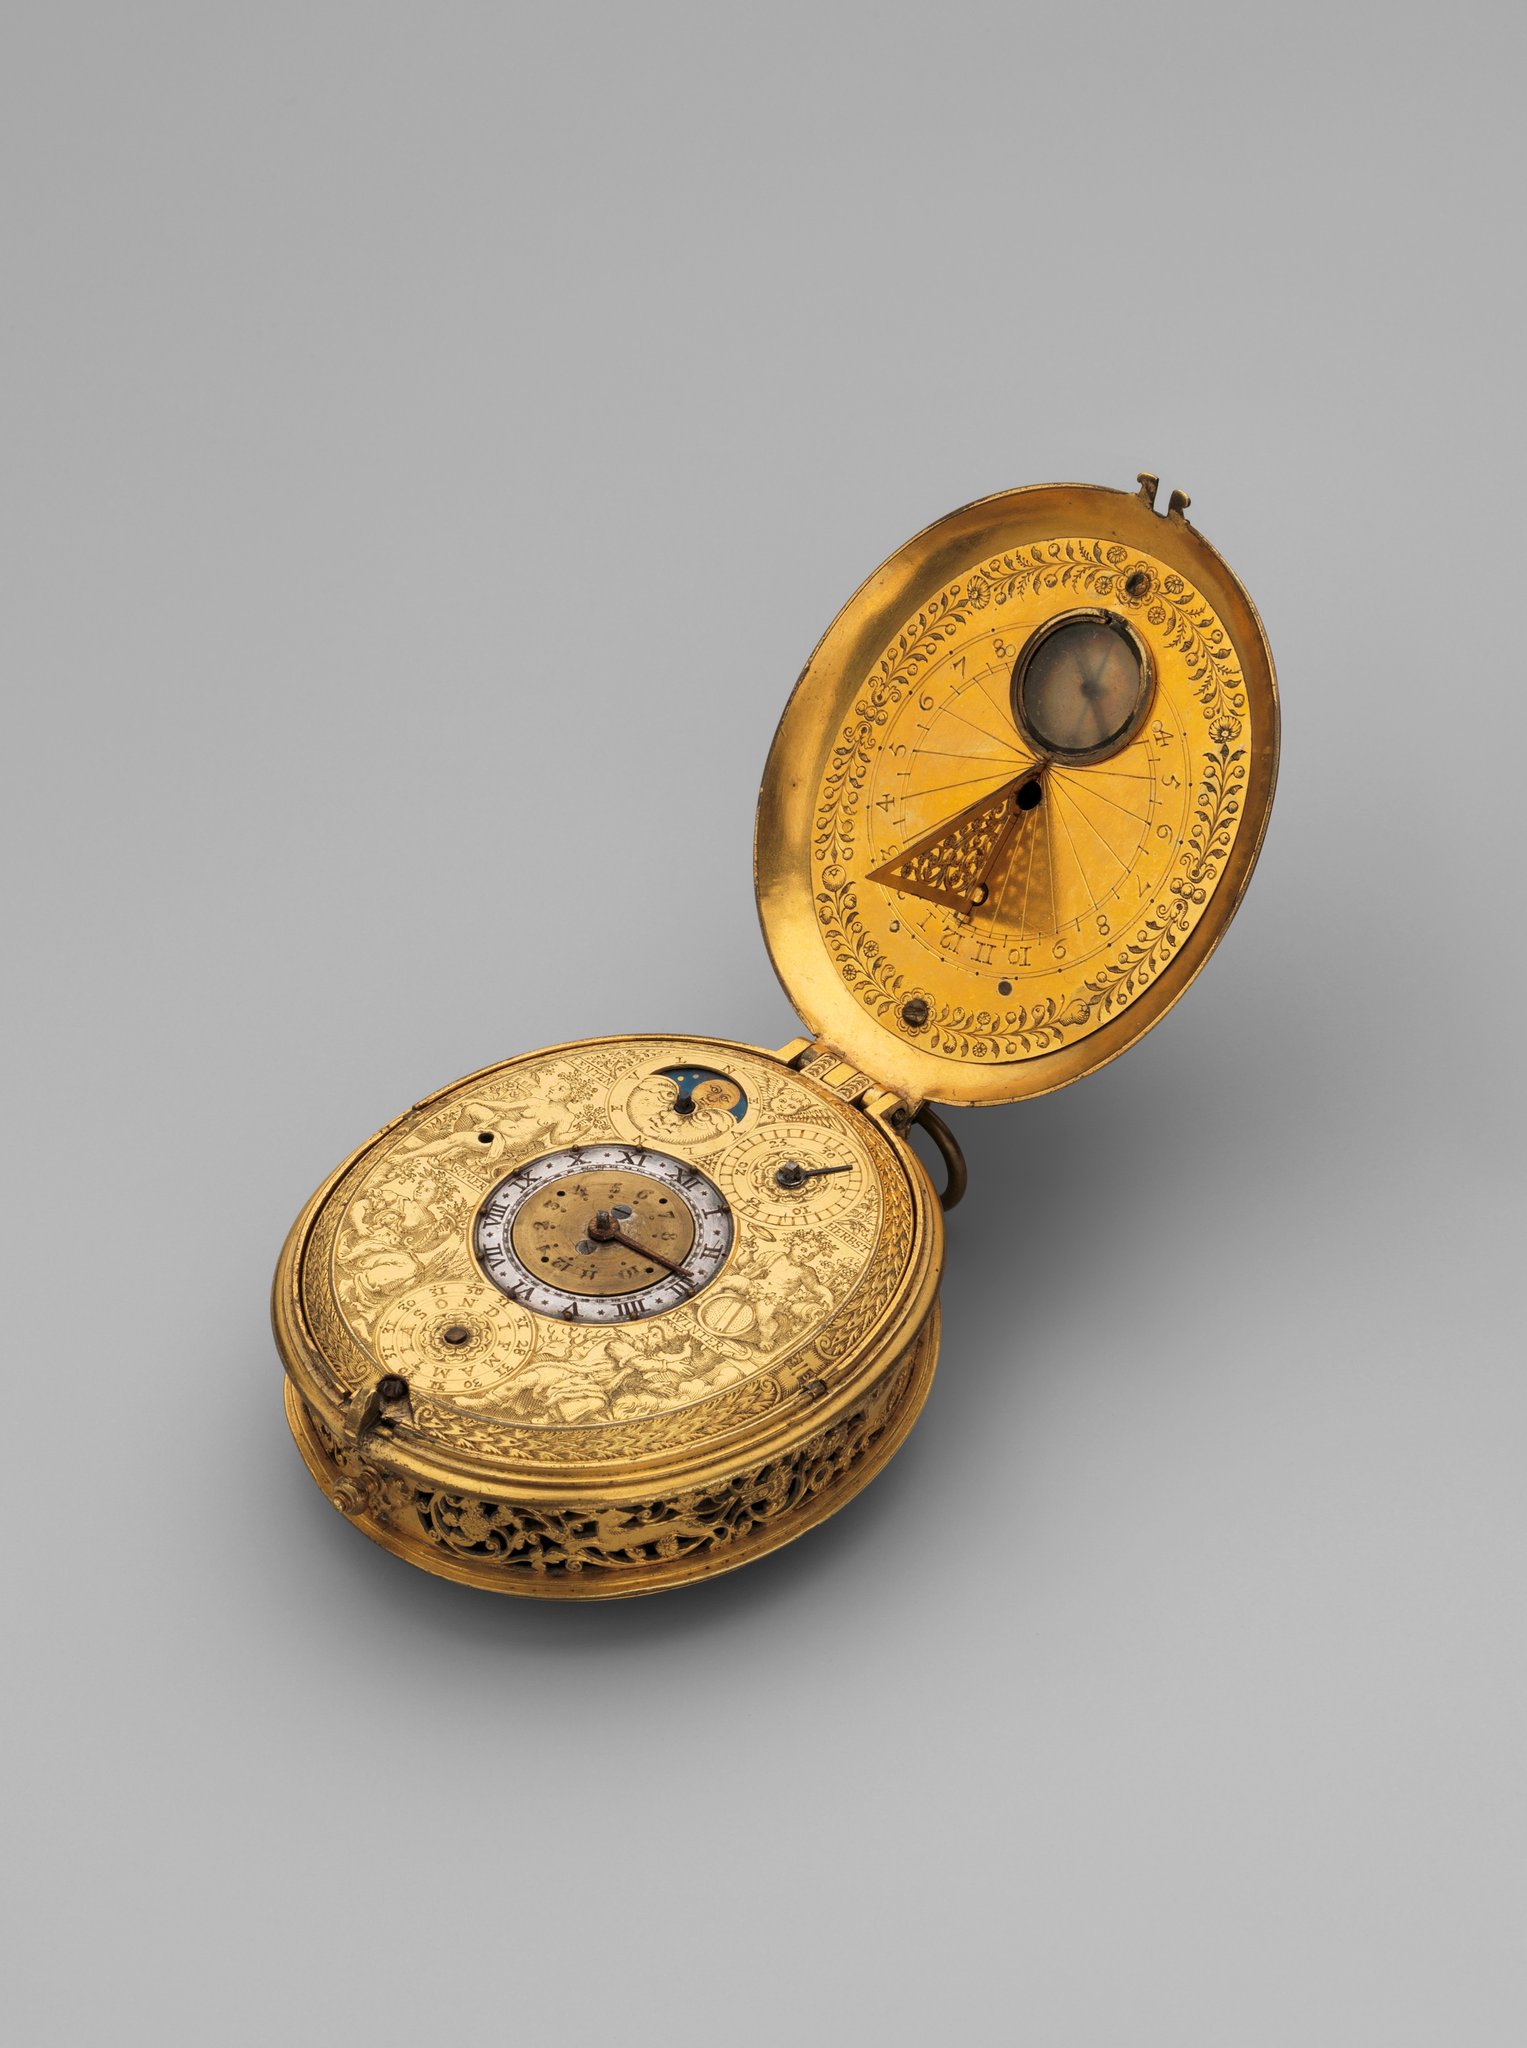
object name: clock watch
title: Clock watch with astronomical dial and sundial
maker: jan jansen bockeltz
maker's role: maker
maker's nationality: dutch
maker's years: 1590-1626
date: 1605-1610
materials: copper, gilt brass, silver, steel